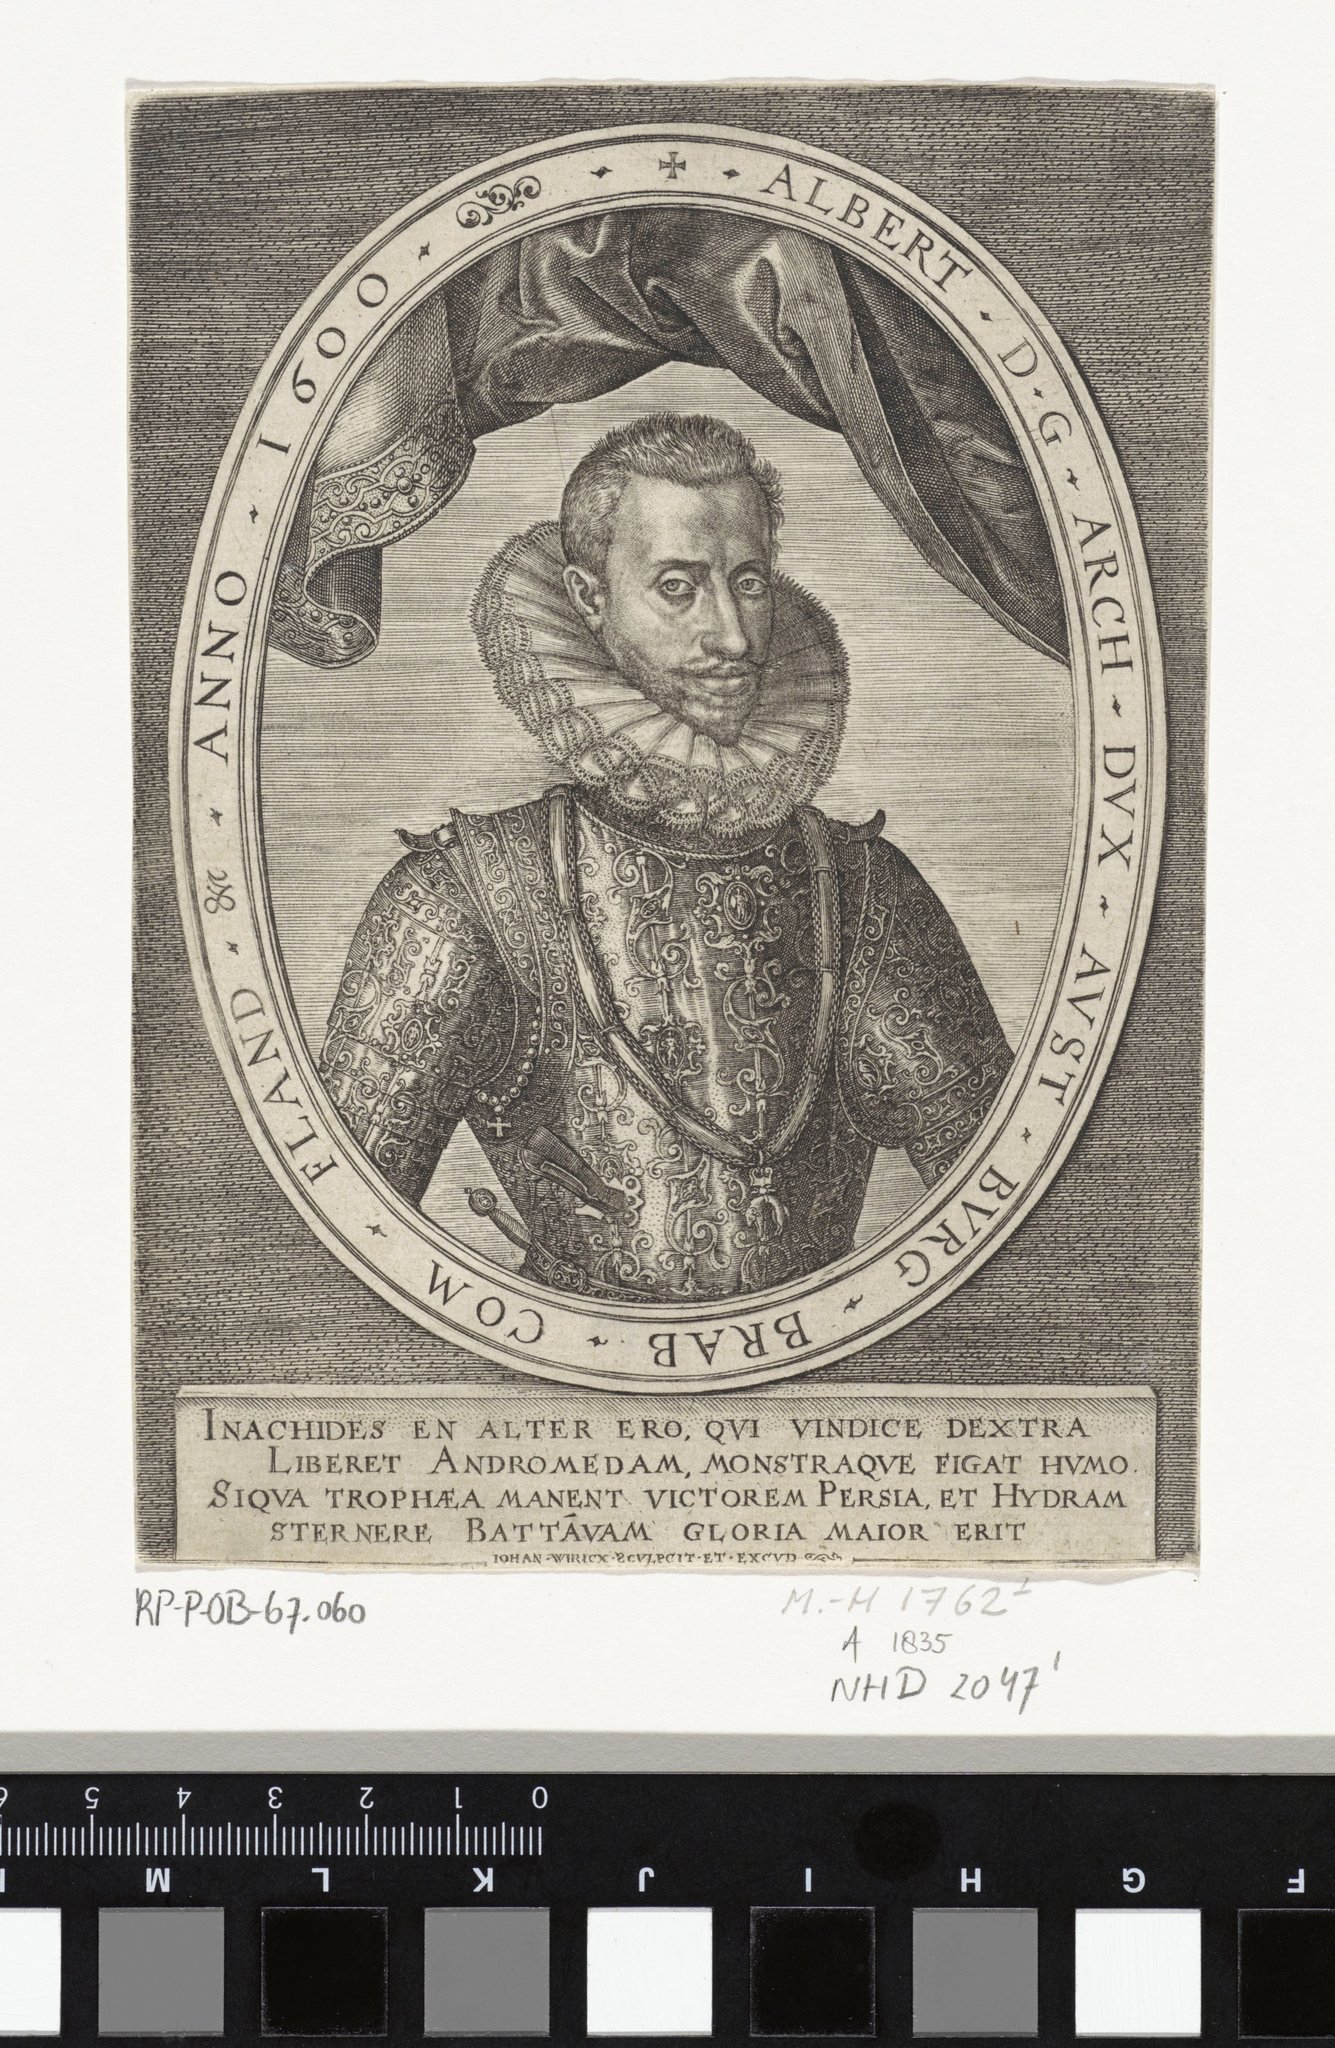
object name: print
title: Portret van Albrecht, aartshertog van Oostenrijk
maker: johannes wierix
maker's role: draughtsman, print maker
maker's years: 1549-1618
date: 1600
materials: paper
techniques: engraving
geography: antwerp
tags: brussels, albrecht aartshertog van oostenrijk, armour, knighthood order of the golden fleece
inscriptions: number: ‘22. - 34.’, collector's mark: Lugt 2228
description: Portret van Albrecht, aartshertog van Oostenrijk. Hij draagt een rijk gedecoreerd harnas en een keten met de Orde van het Gulden Vlies. De voorstelling is gevat in een ovale omlijsting met een randschrift in het Latijn. In het kader een vierregelig onderschrift in het Latijn.